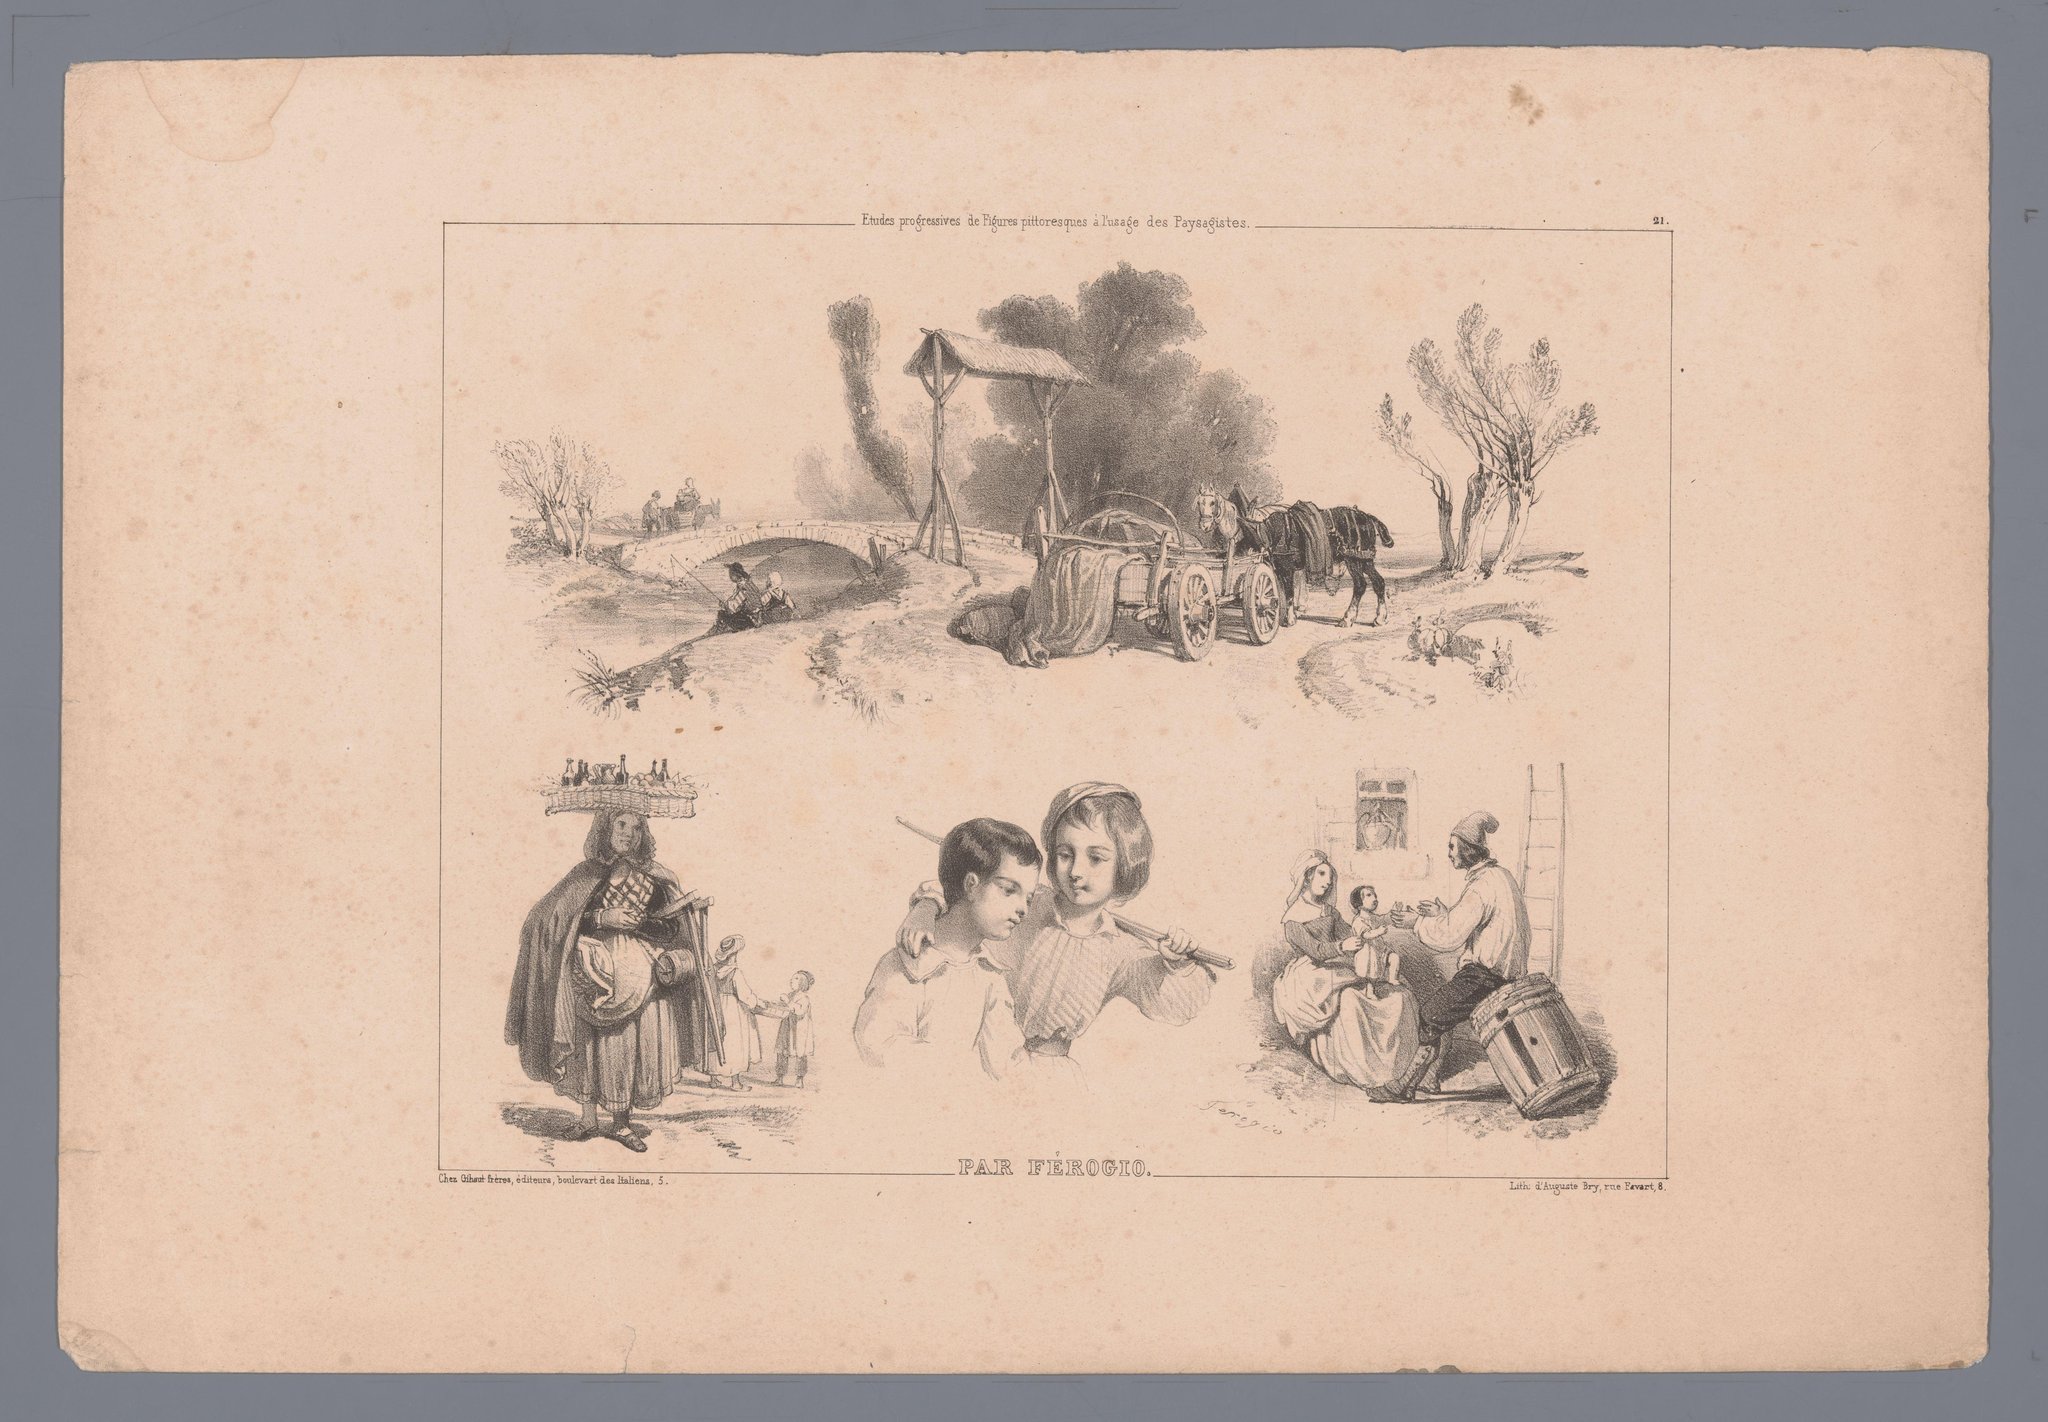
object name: print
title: Voorbeelden van figuurstudies voor landschapskunstenaars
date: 1839-1845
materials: paper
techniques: lithograph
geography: paris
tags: parents with their children, street-trader - bb - women engaged in trade and commerce, landscape with bridge, viaduct or aqueduct, four-wheeled vehicle drawn by two animals, child between toddler and youth (of undetermined sex)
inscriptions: collector's mark: Lugt 2228a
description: Prent maakt deel uit van een omslag met vijf prenten.